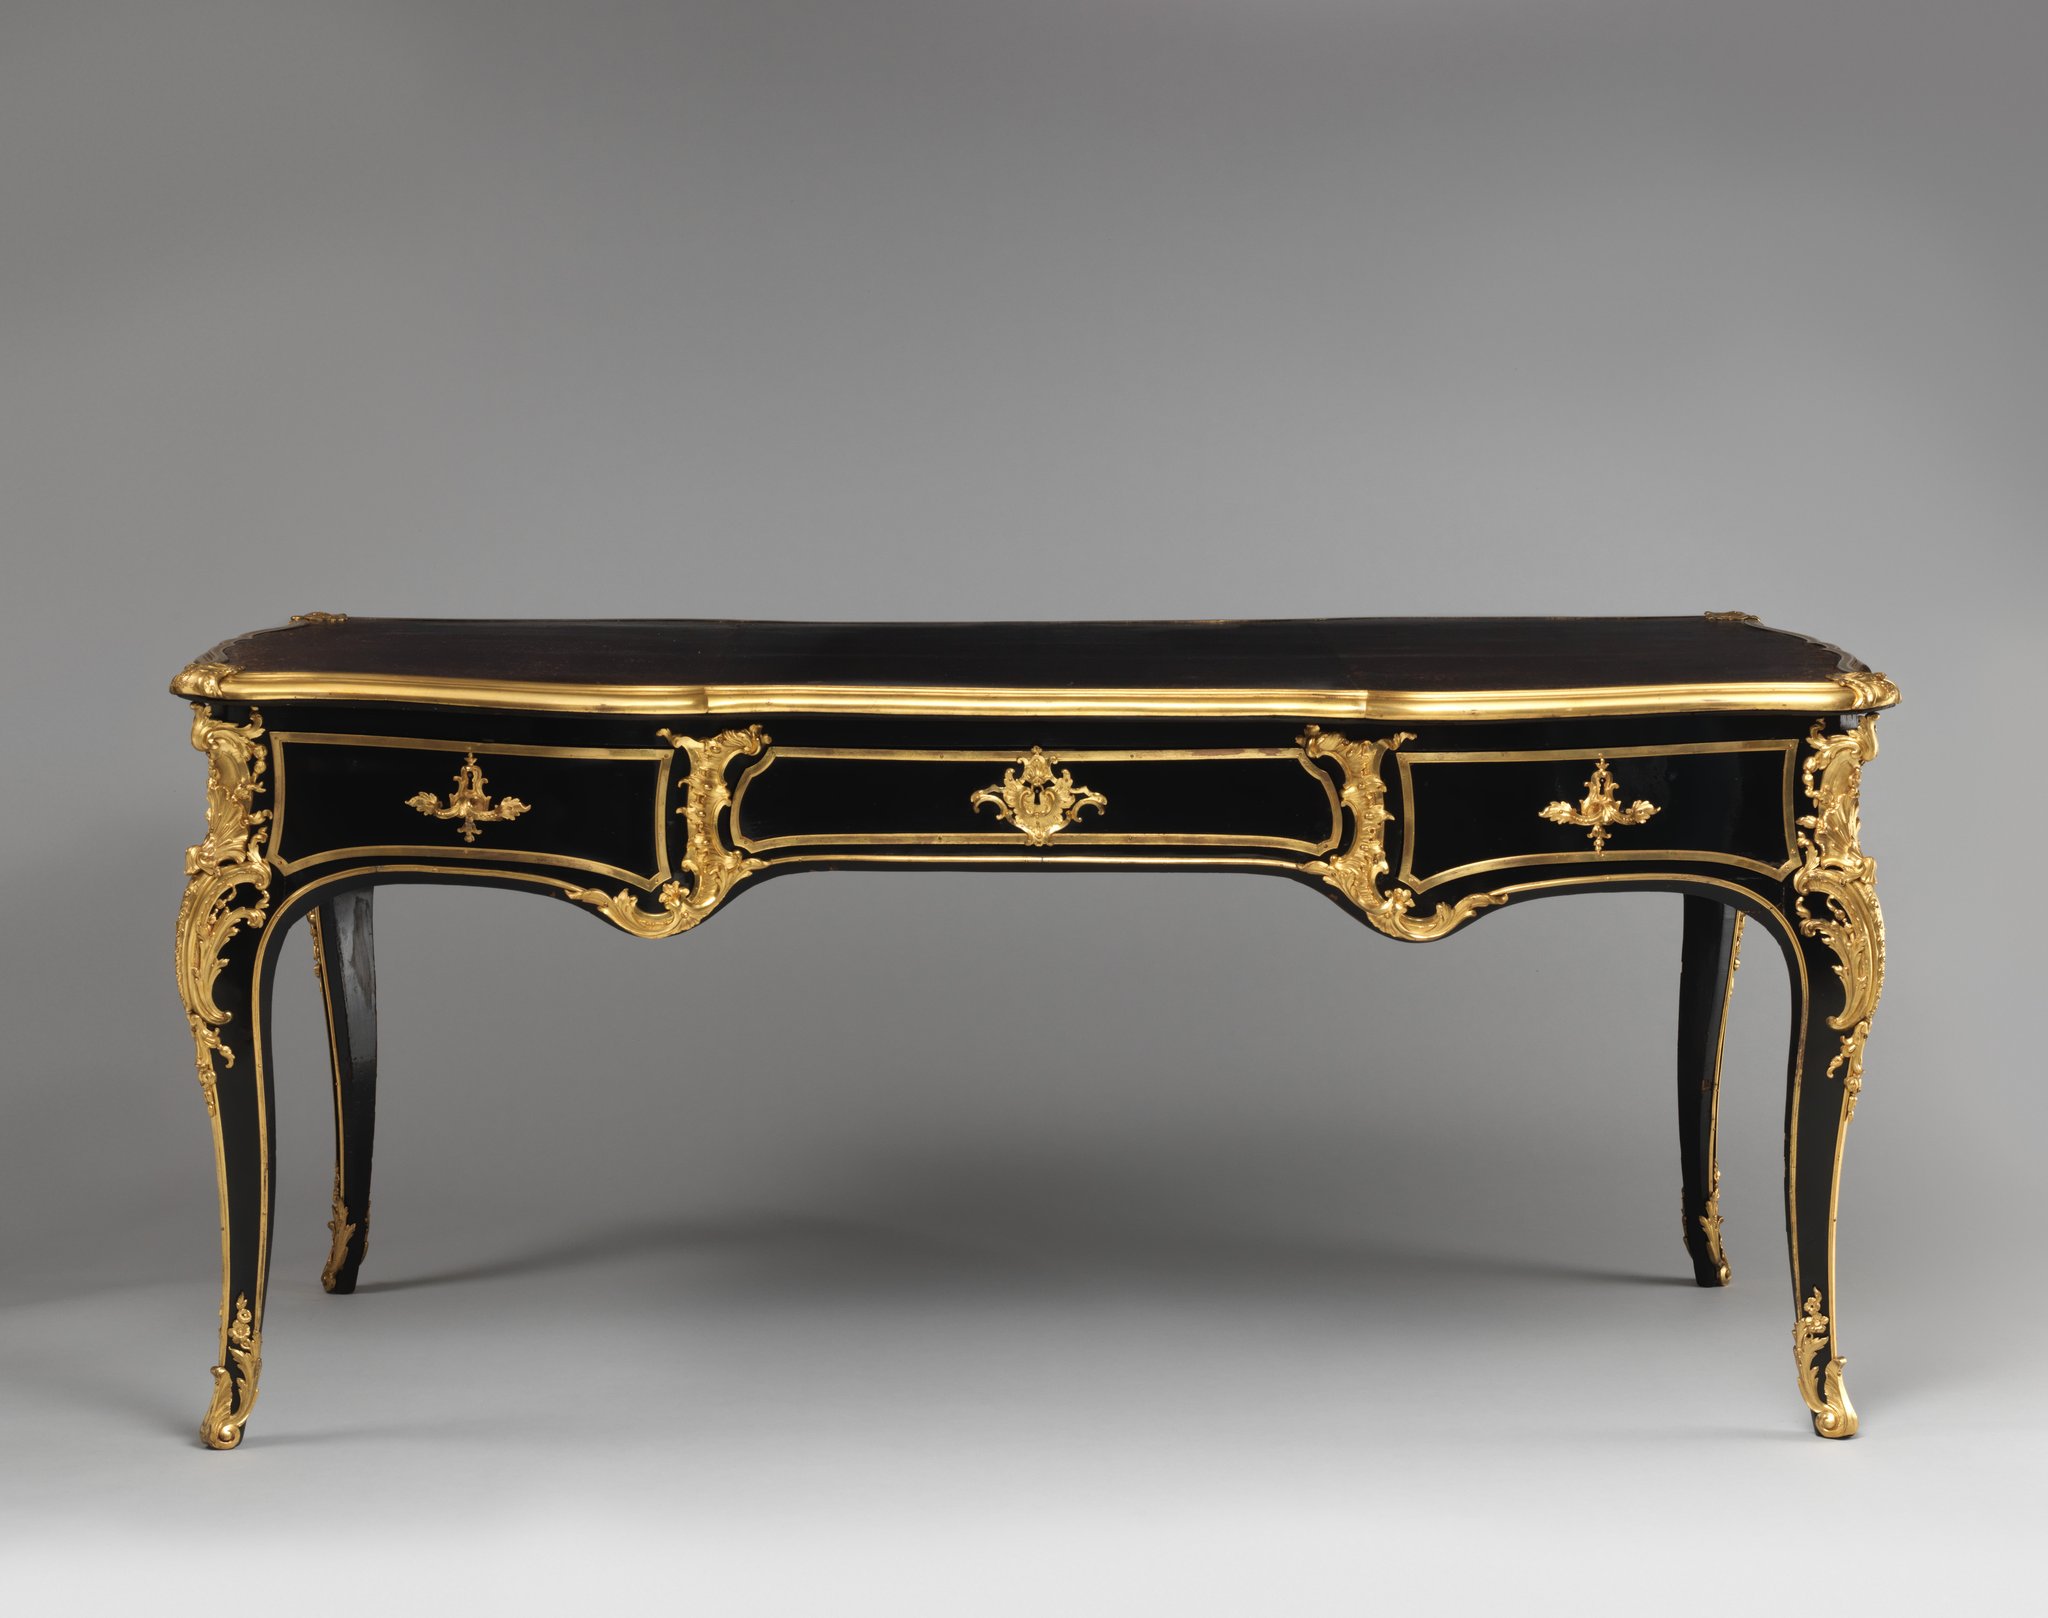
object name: writing table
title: Writing table (bureau plat)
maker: bernard ii van risenburgh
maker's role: maker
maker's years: 1696-1767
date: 1745-1750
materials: bronze, wood, gilt, leather, panel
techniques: chasing, gilding, inlay, tooling, veneering